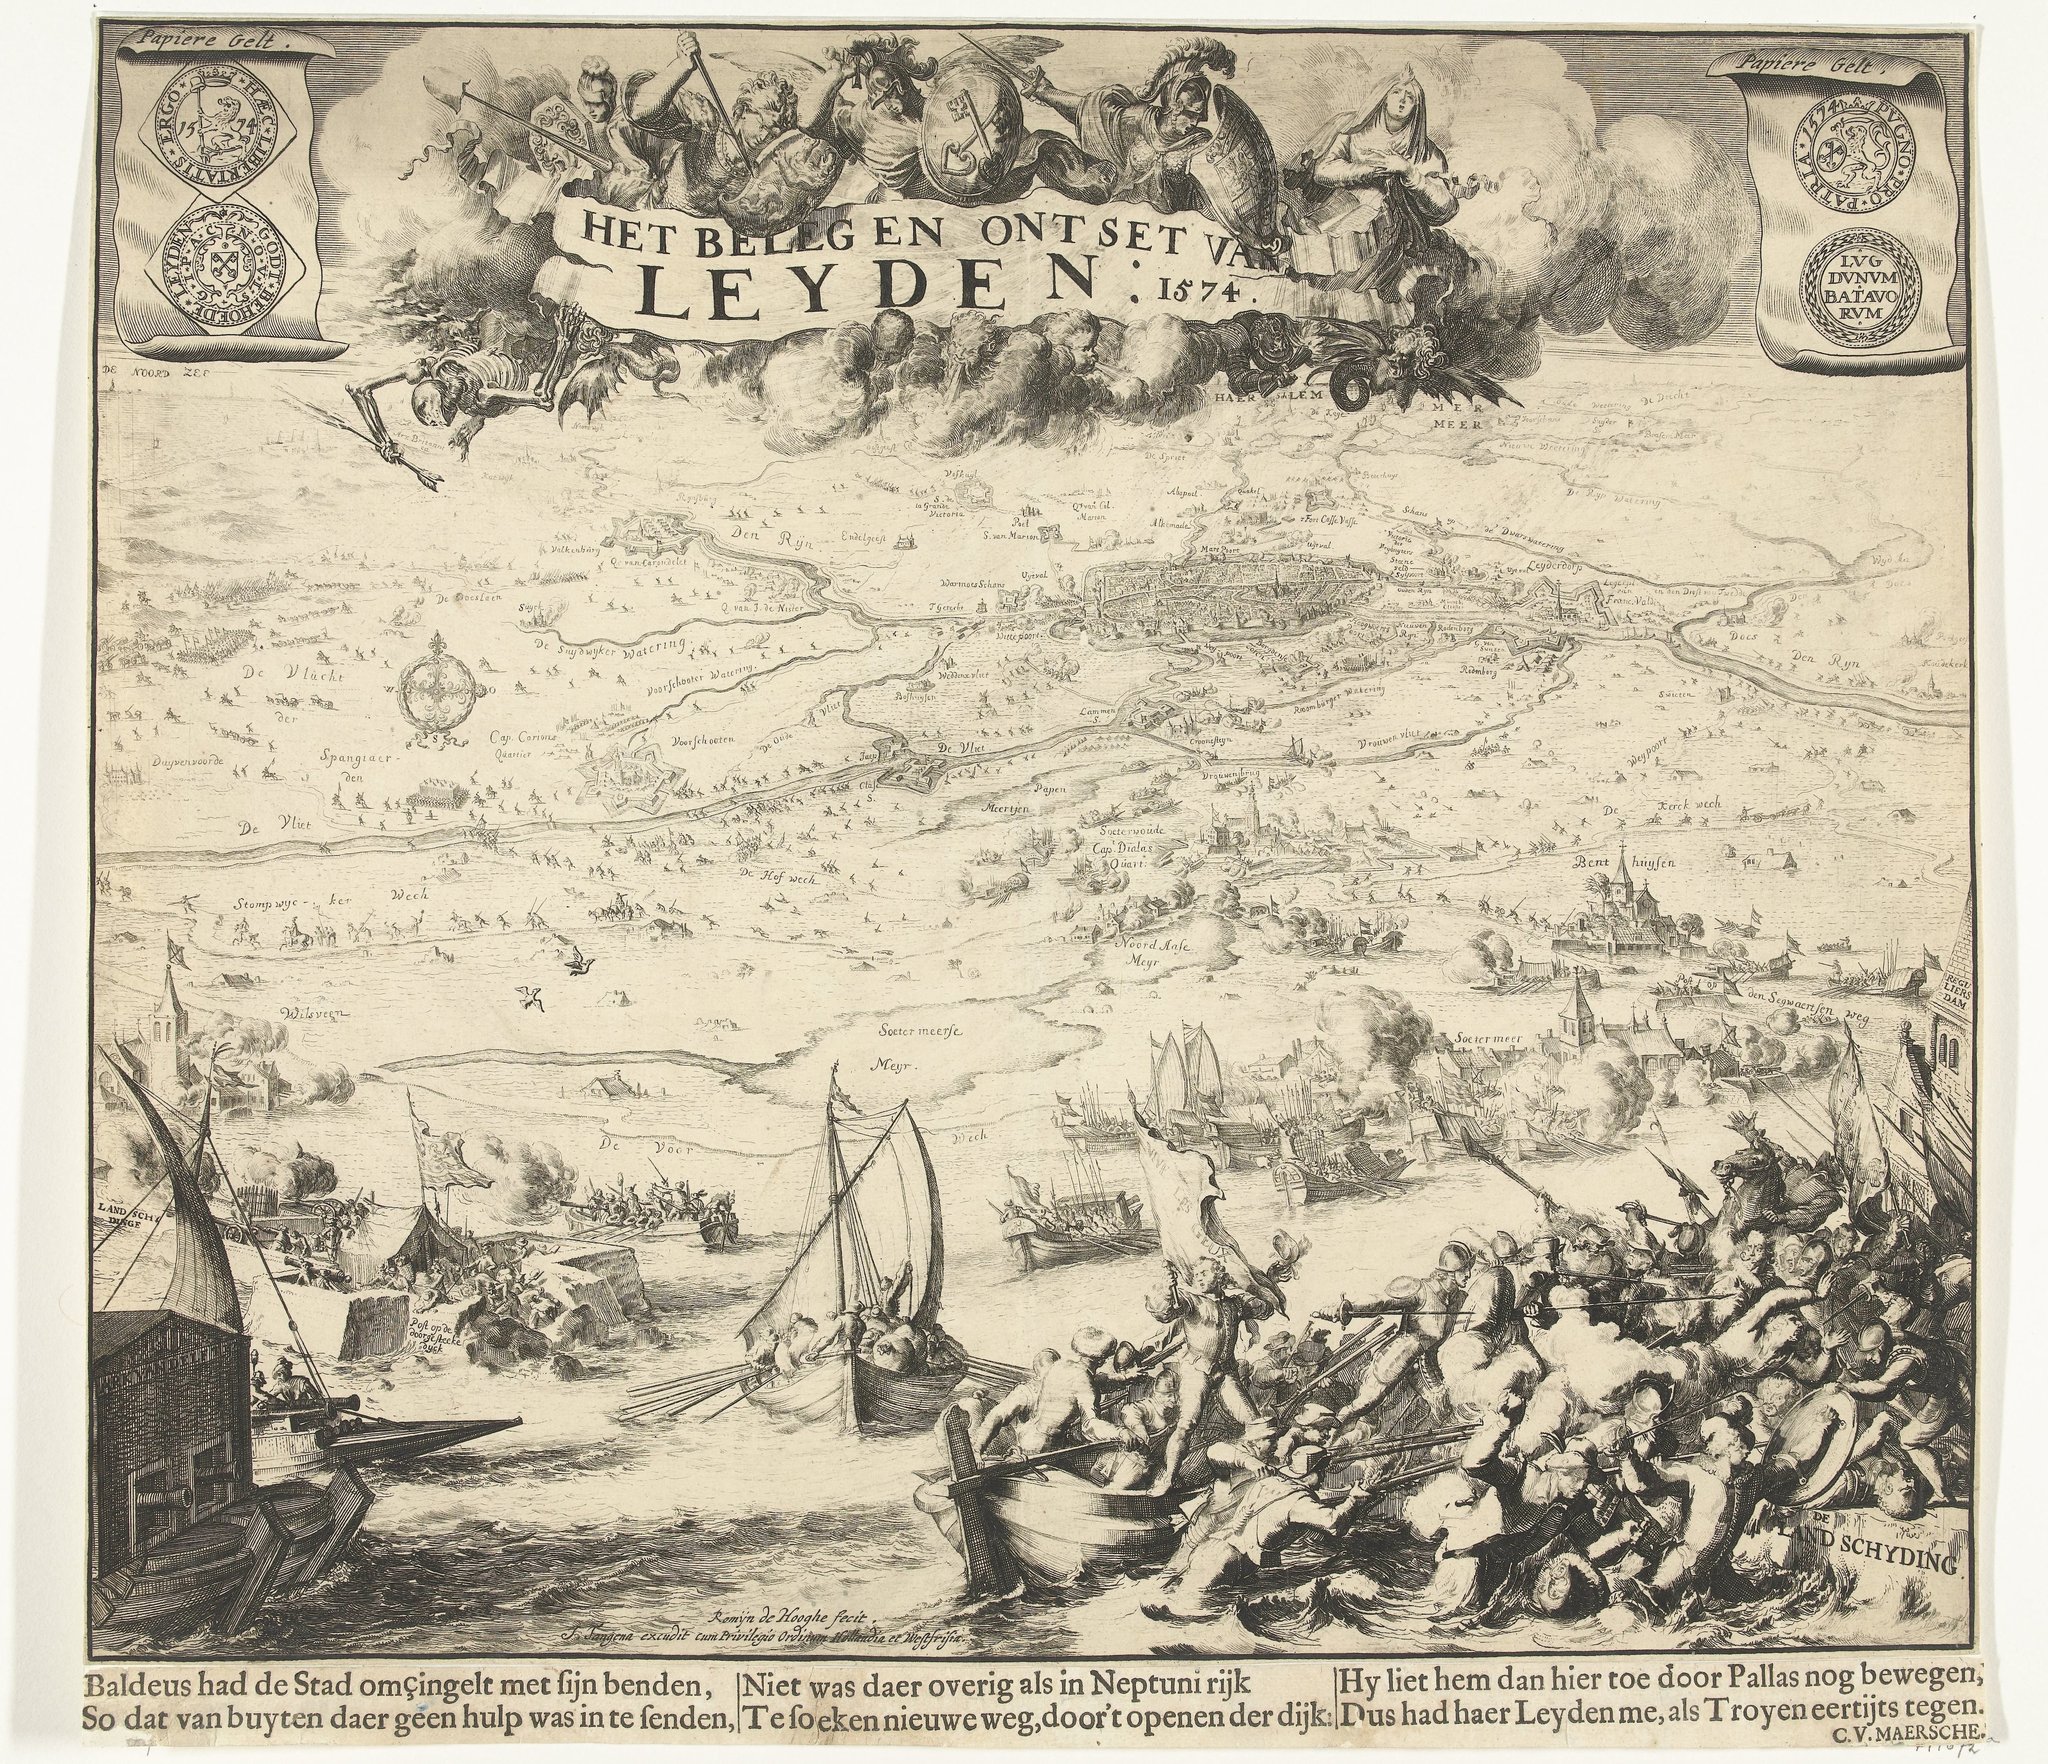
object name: history print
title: Het beleg en ontset van Leyden: 1574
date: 1687-1691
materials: paper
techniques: engraving, etching, letterpress printing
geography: northern netherlands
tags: raising the siege with outside assistance, relief, siege, position war, leiden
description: Beleg en ontzet van Leiden, 1574. Kaart van Leiden en omgeving in vogelvluchtperspectief, op de voorgrond gevechten tussen geuzen en de Spaanse soldaten. Boven de titel in wolken wordt een allegorische strijd gevoerd door personificaties van de Vrijheid, Holland, Leiden, Oranje en het ware Geloof. Aan weerszijden voorbeelden van het papieren noodgeld tijdens het beleg in omloop gebracht. Onder de plaat is een vers geplakt van 3 keer 2 regels in het Nederlands. Bij deze prent behoort een afzonderlijk tekstblad.